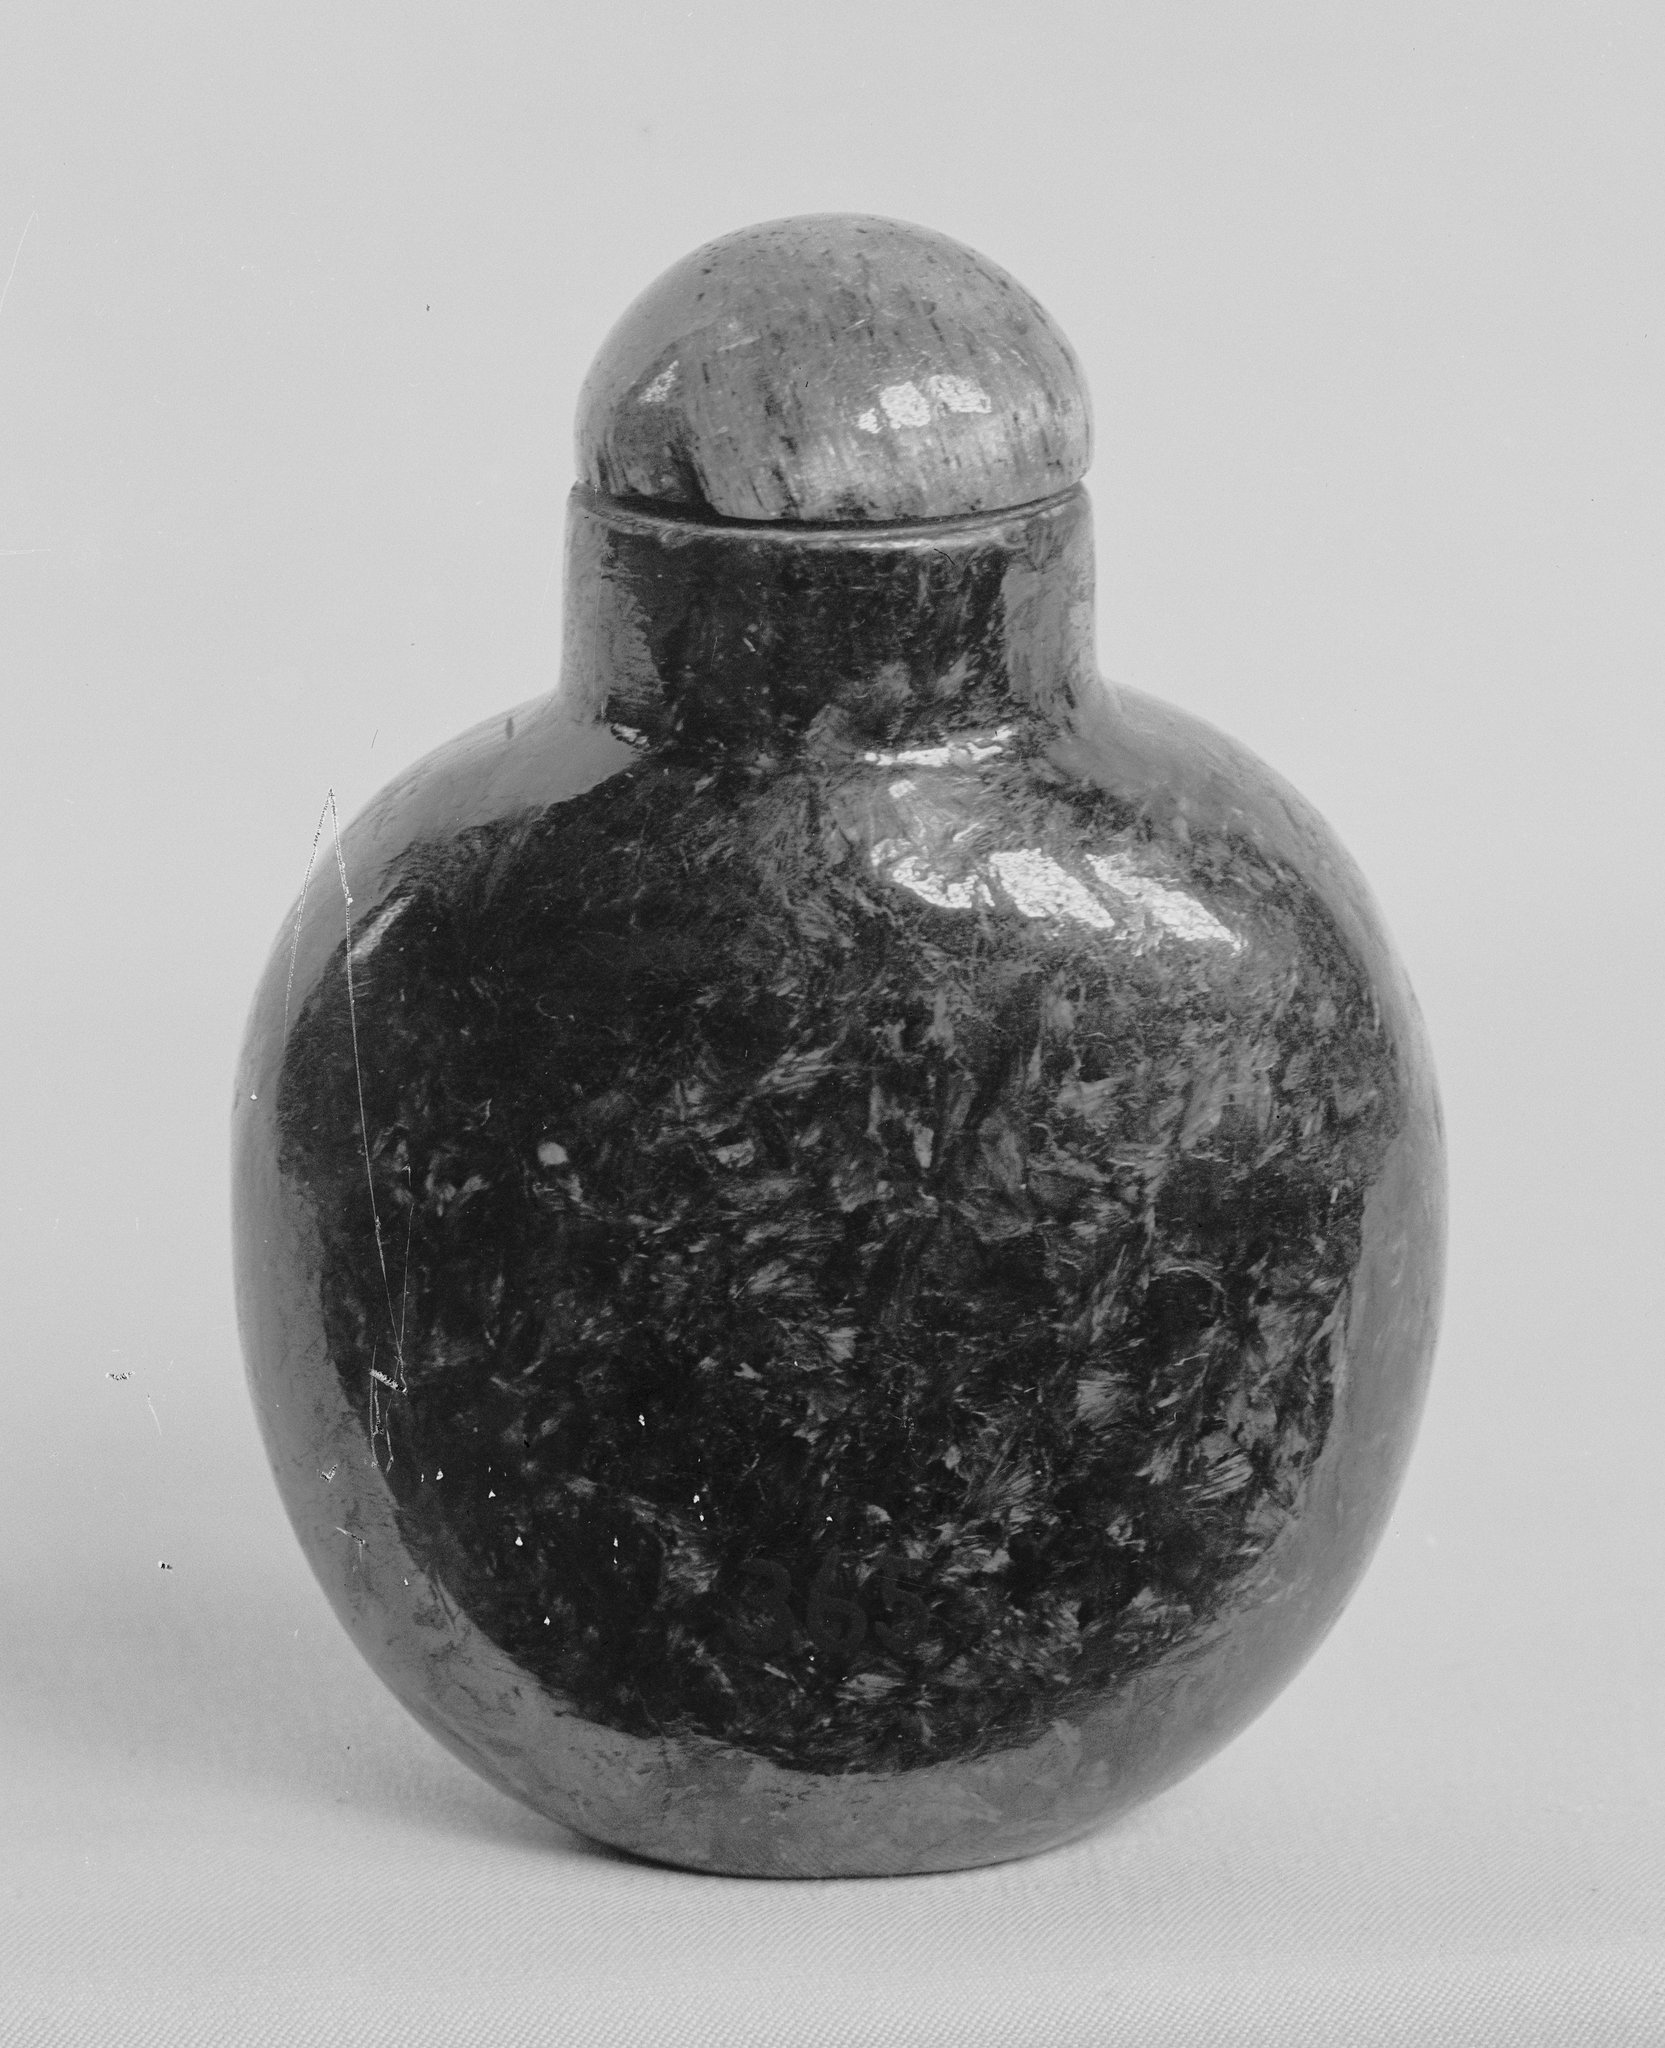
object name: snuff bottle with stopper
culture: chinese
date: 1644-1911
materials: jade